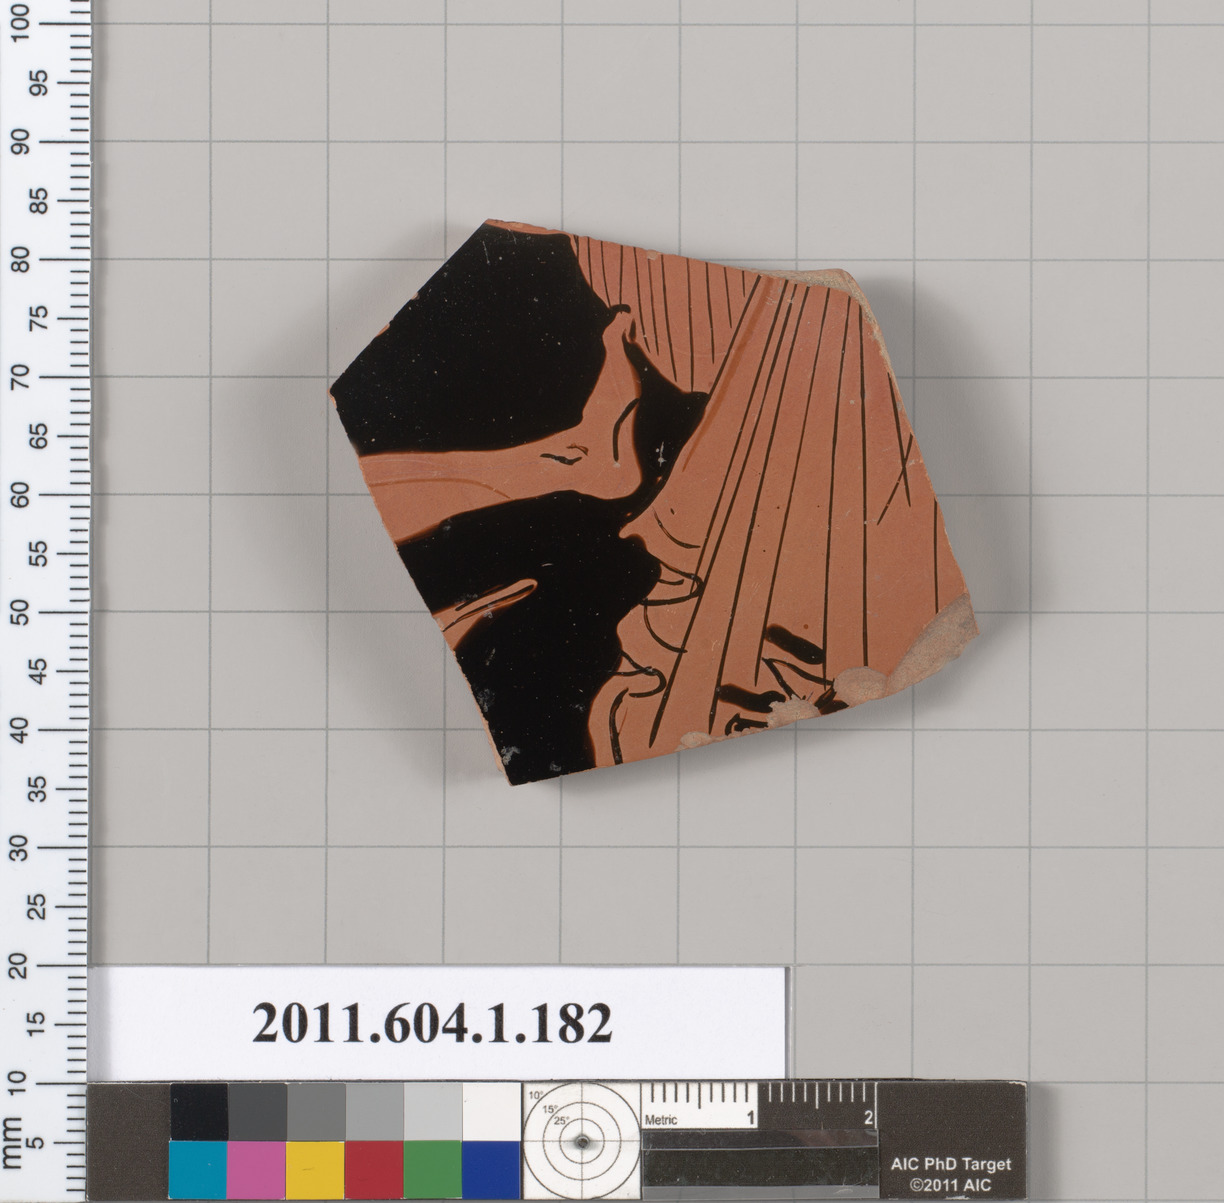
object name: kylix fragment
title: Terracotta fragment of a kylix (drinking cup)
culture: greek, attic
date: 475-451 BCE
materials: terracotta